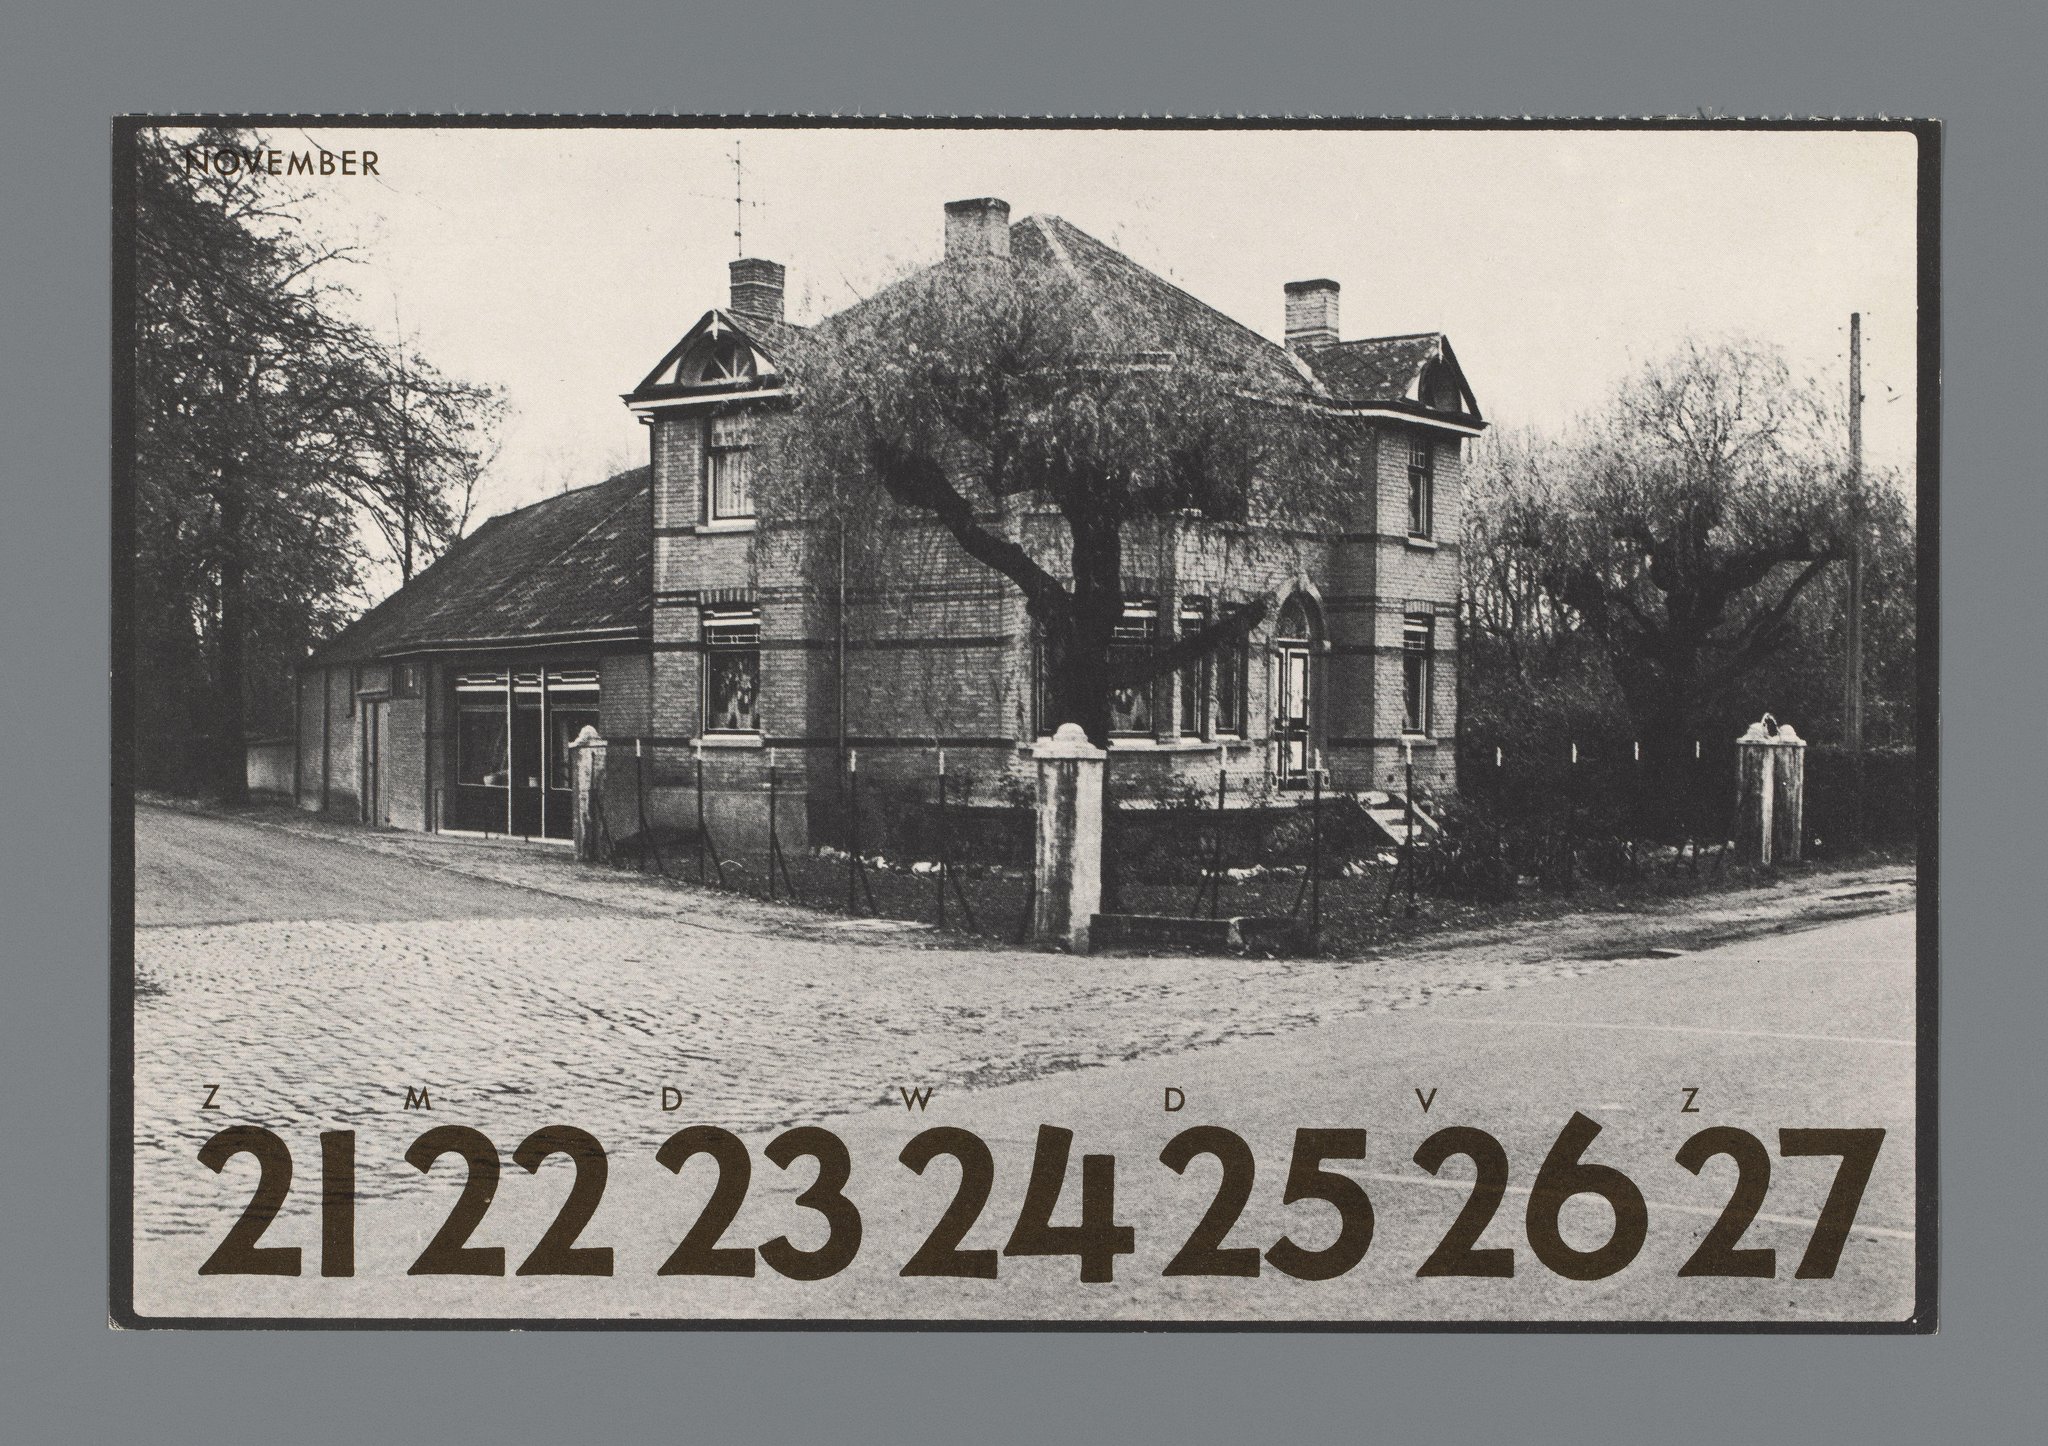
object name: photograph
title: België. Huizen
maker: Anonymous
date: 1900-1950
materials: paper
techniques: offset printed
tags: belgium